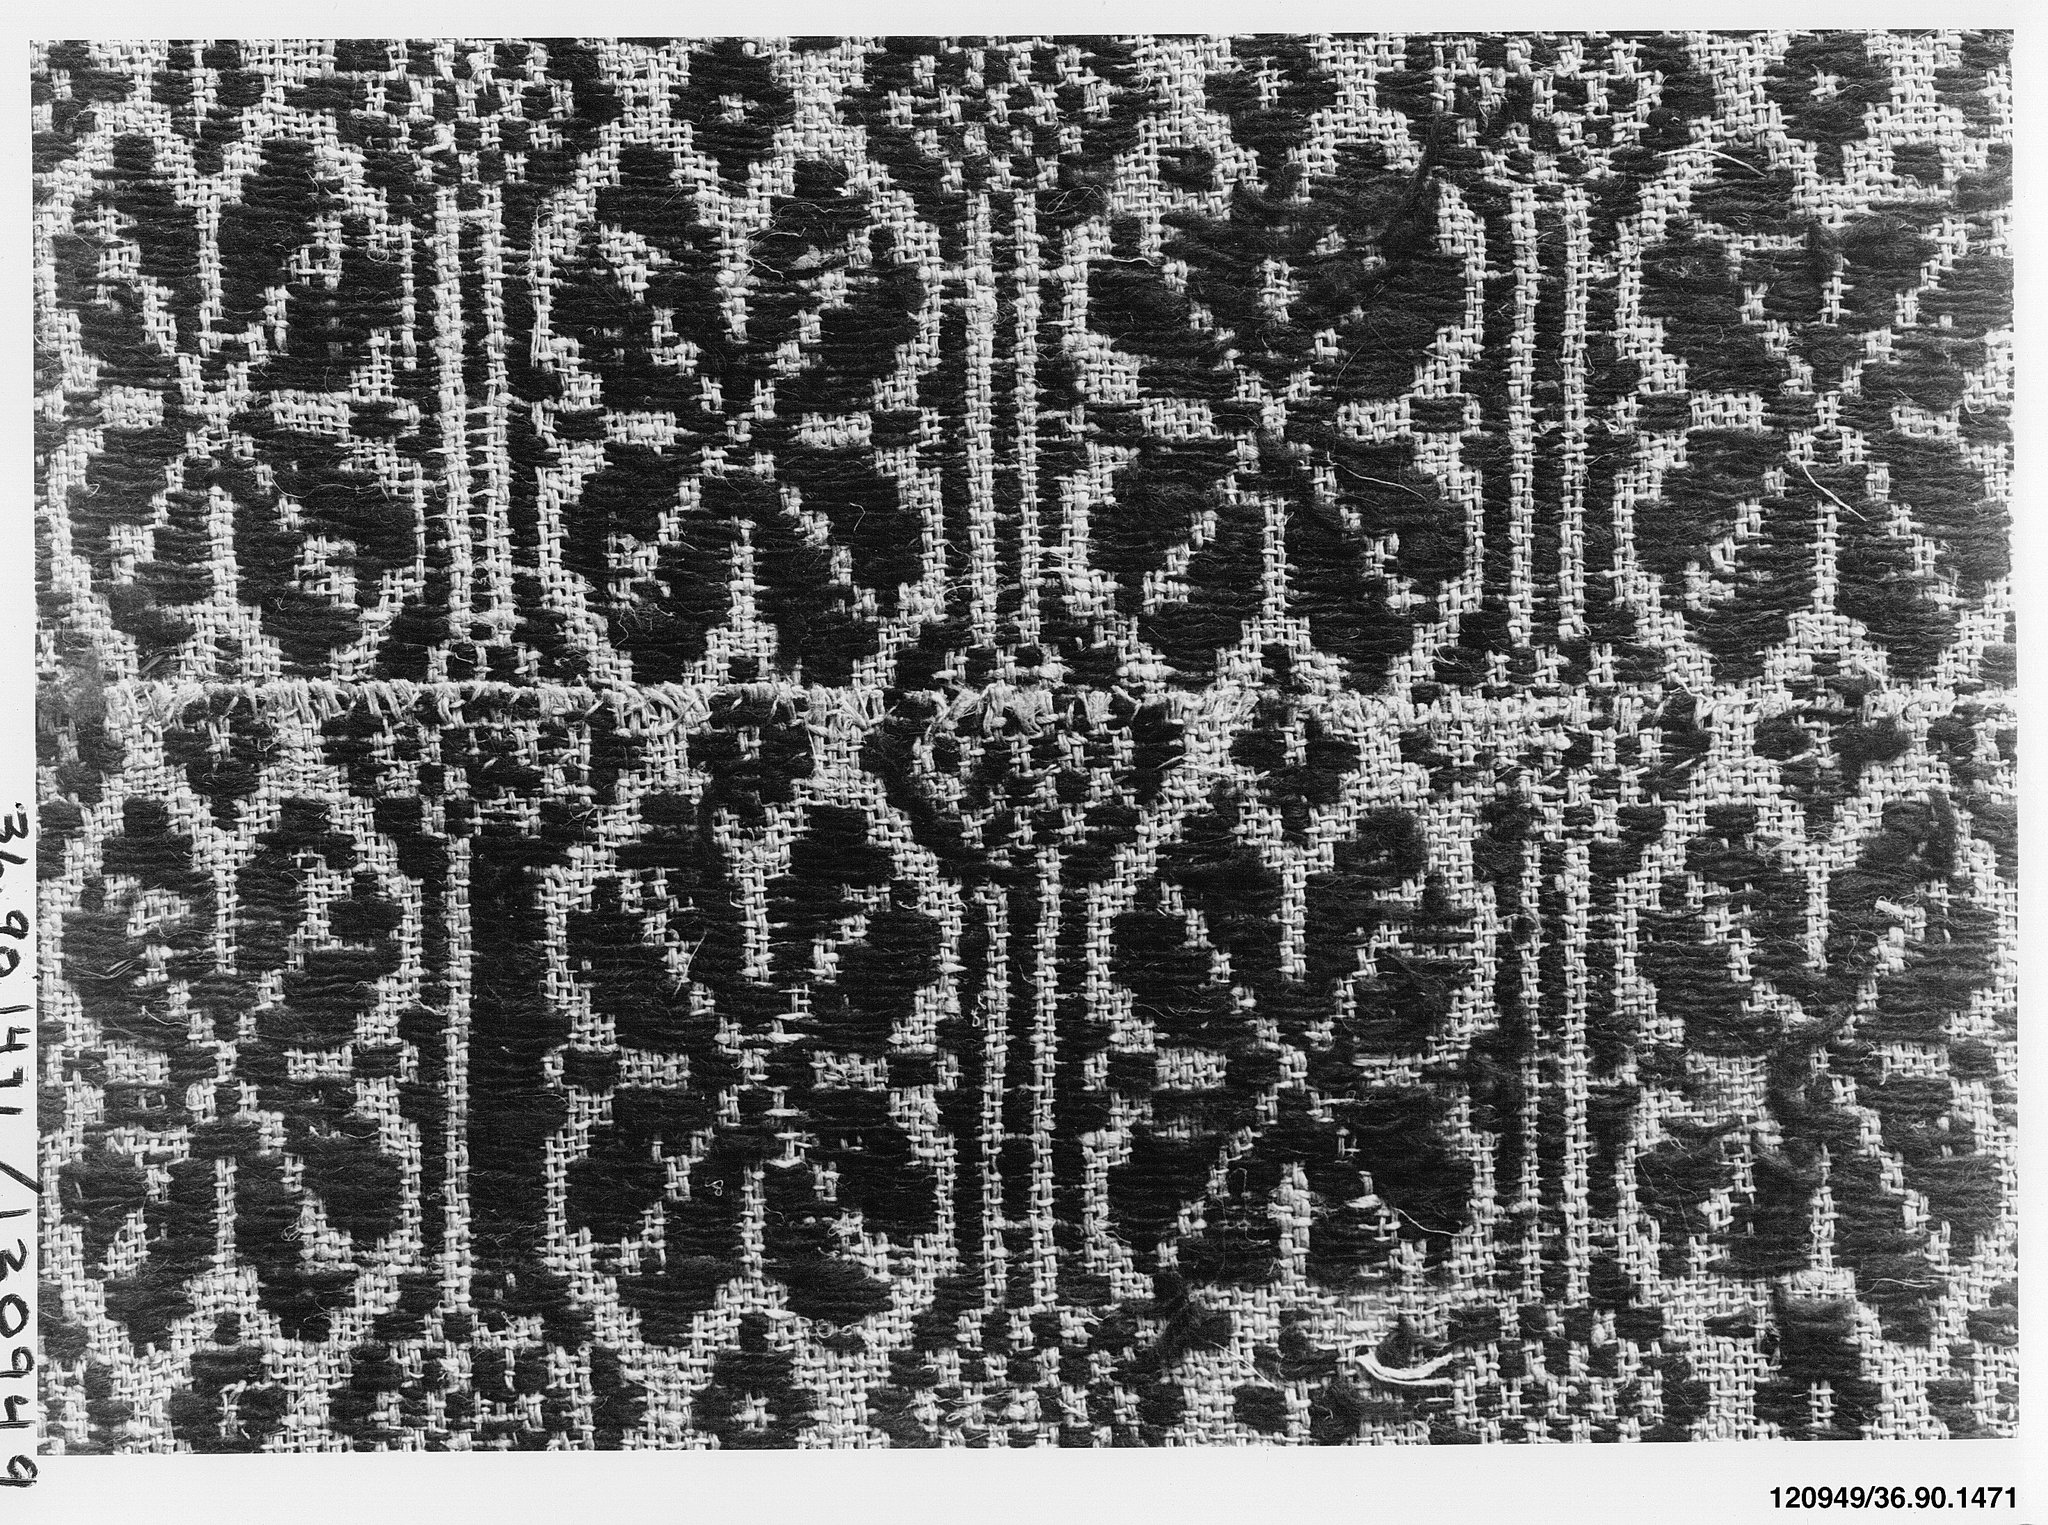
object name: piece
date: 1601-1700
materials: linen, wool